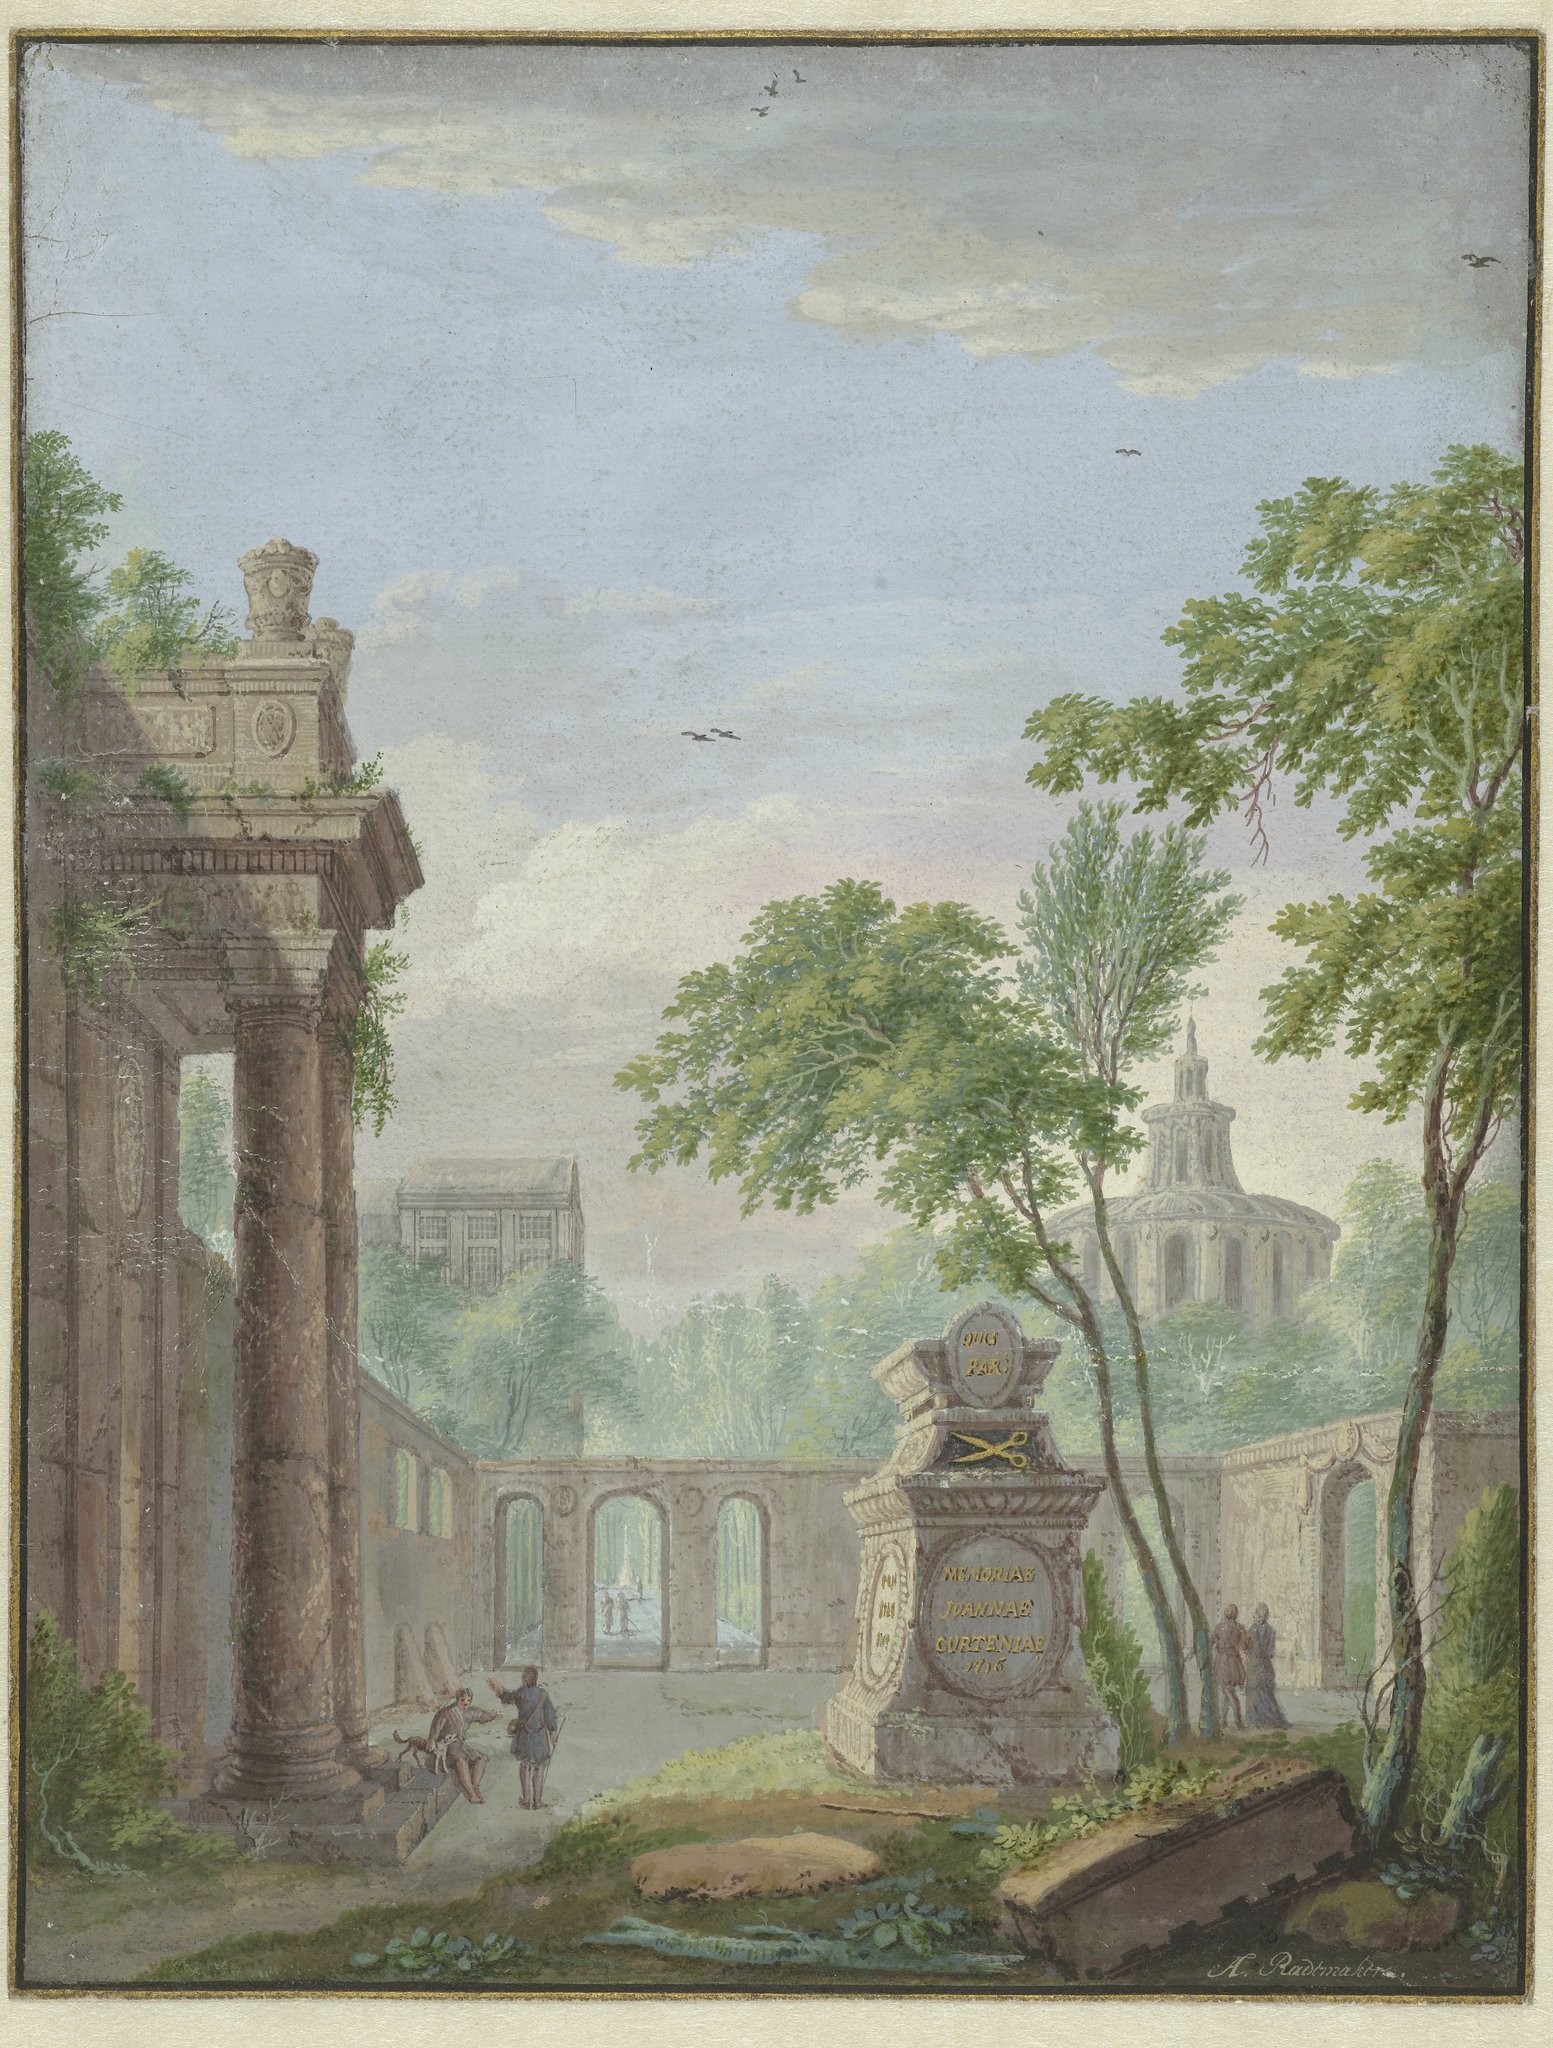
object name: drawing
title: Tuin met een tombe ter nagedachtenis aan Johanna Koerten Blok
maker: abraham rademaker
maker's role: draughtsman, print maker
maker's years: 1676-1735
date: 1716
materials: paint, gouache, paper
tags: amsterdam, johanna koerten, fantastic architecture, unrealistic architectural fantasies, grave-building, monumental tomb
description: Een met klassieke architectuur omzoomde tuin met een tombe met opschrift ter nagedachtenis aan de papierknipster Johanna Koerten Blok.